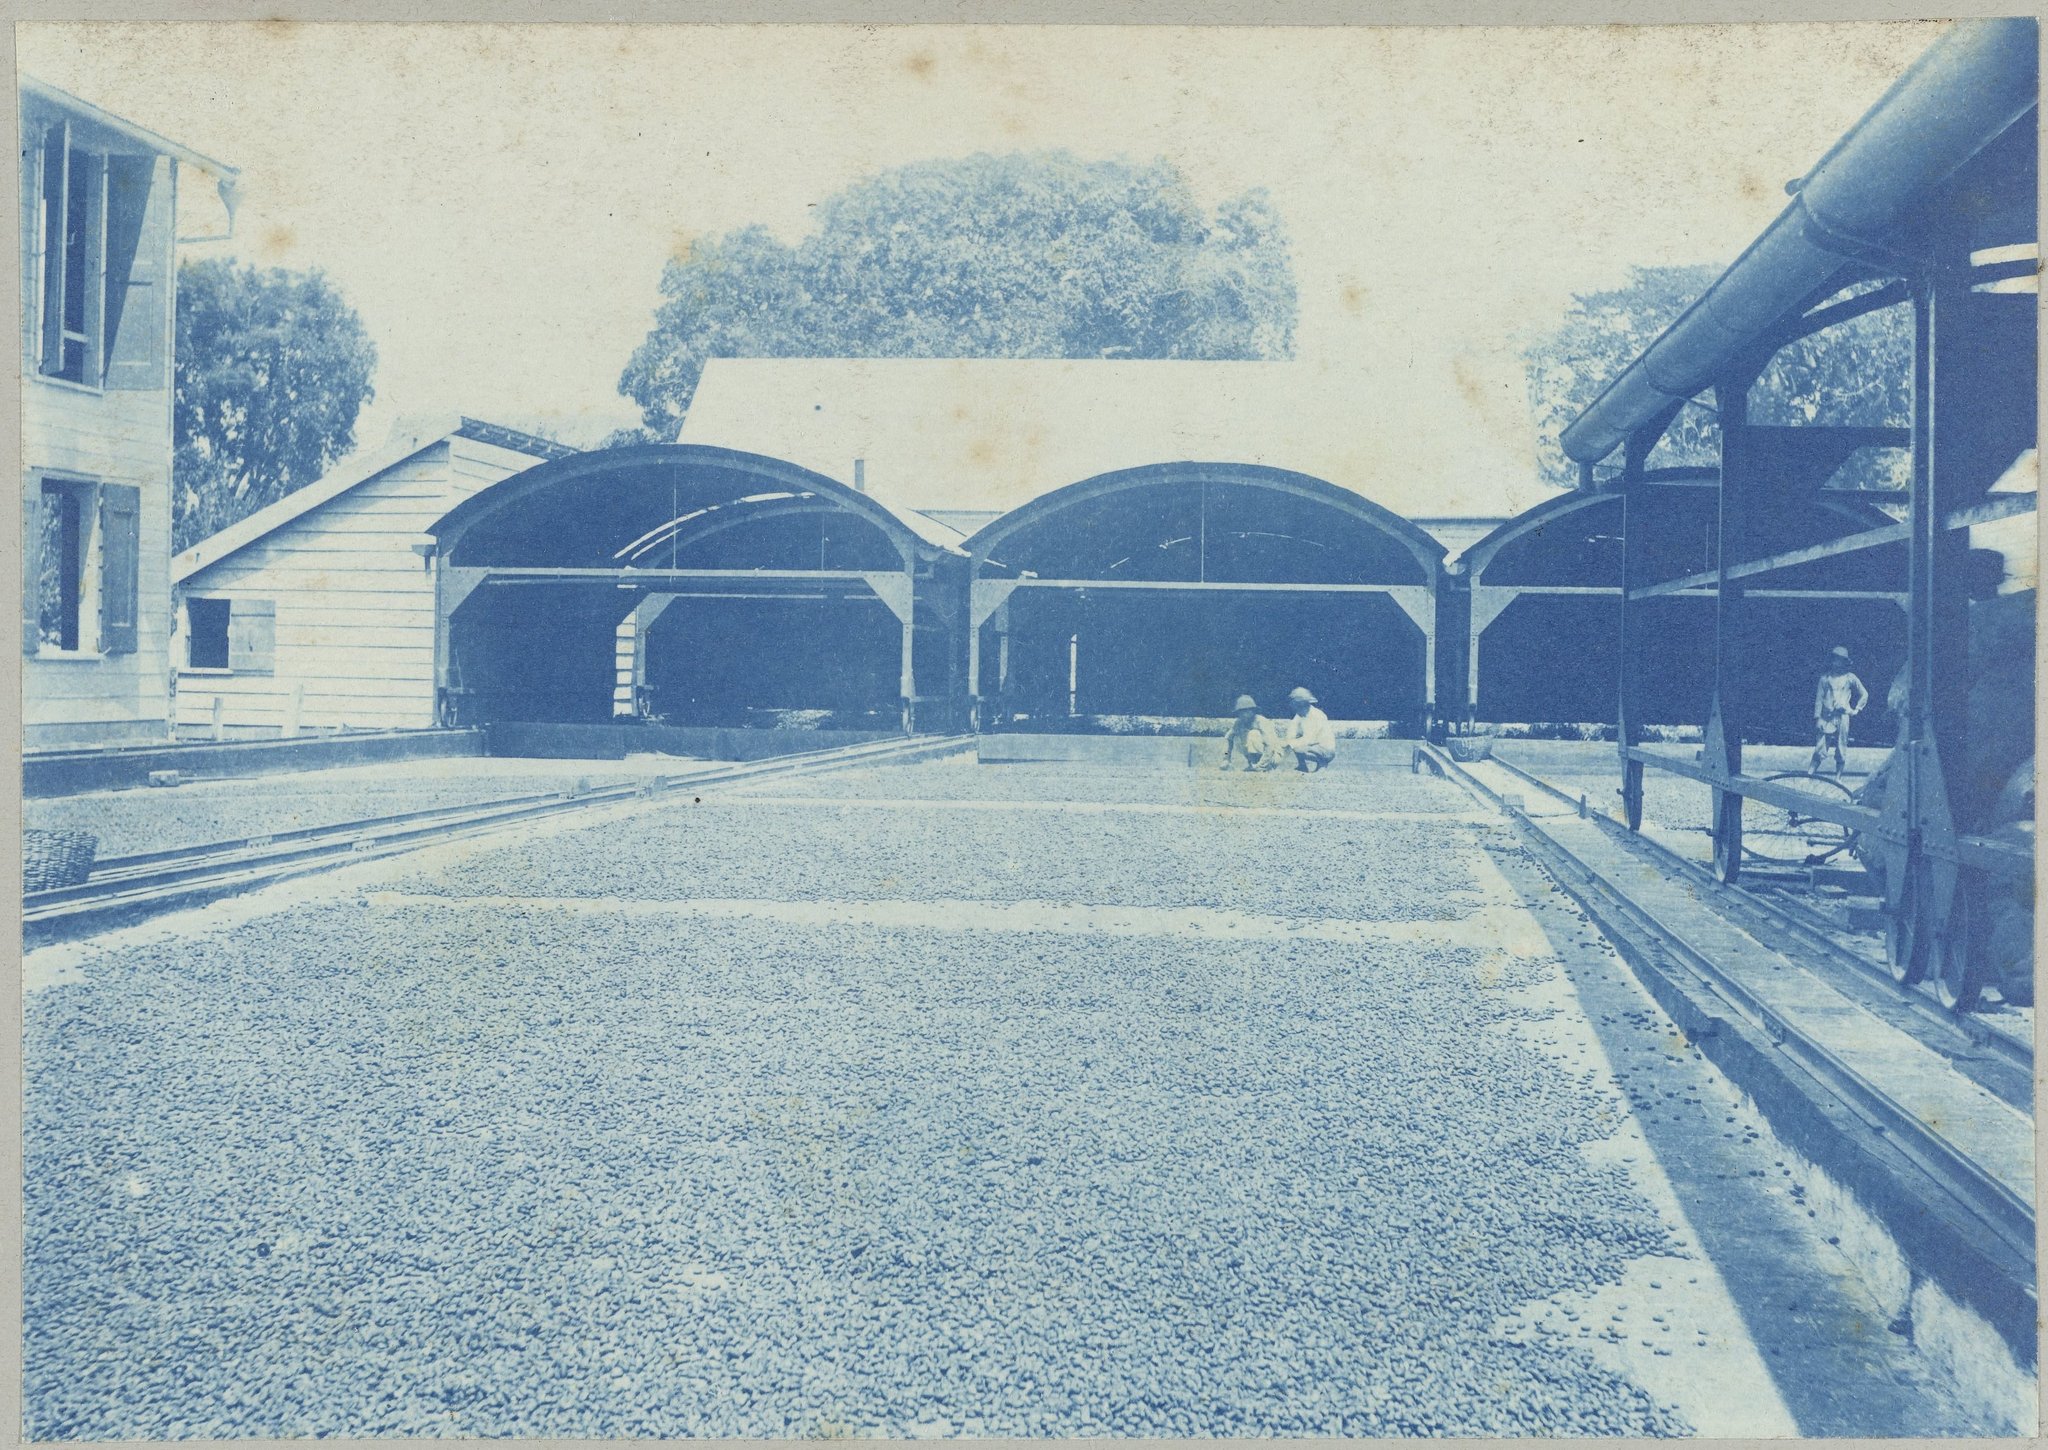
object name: photograph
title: Droogvloer op "Ma retraite"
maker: hendrik doijer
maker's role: engineer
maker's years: 1863-1925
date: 1903-1910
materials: photographic support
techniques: cyanotype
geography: suriname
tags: suriname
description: Cacaobonen drogend in de zon op droogvloeren bij loodsen op het terrein van de plantage Ma Retraite. Onderdeel van het fotoalbum Souvenir de Voyage (deel 1), over het leven van de familie Doijer in en rond de plantage Ma Retraite in Suriname in de jaren 1903-1910.